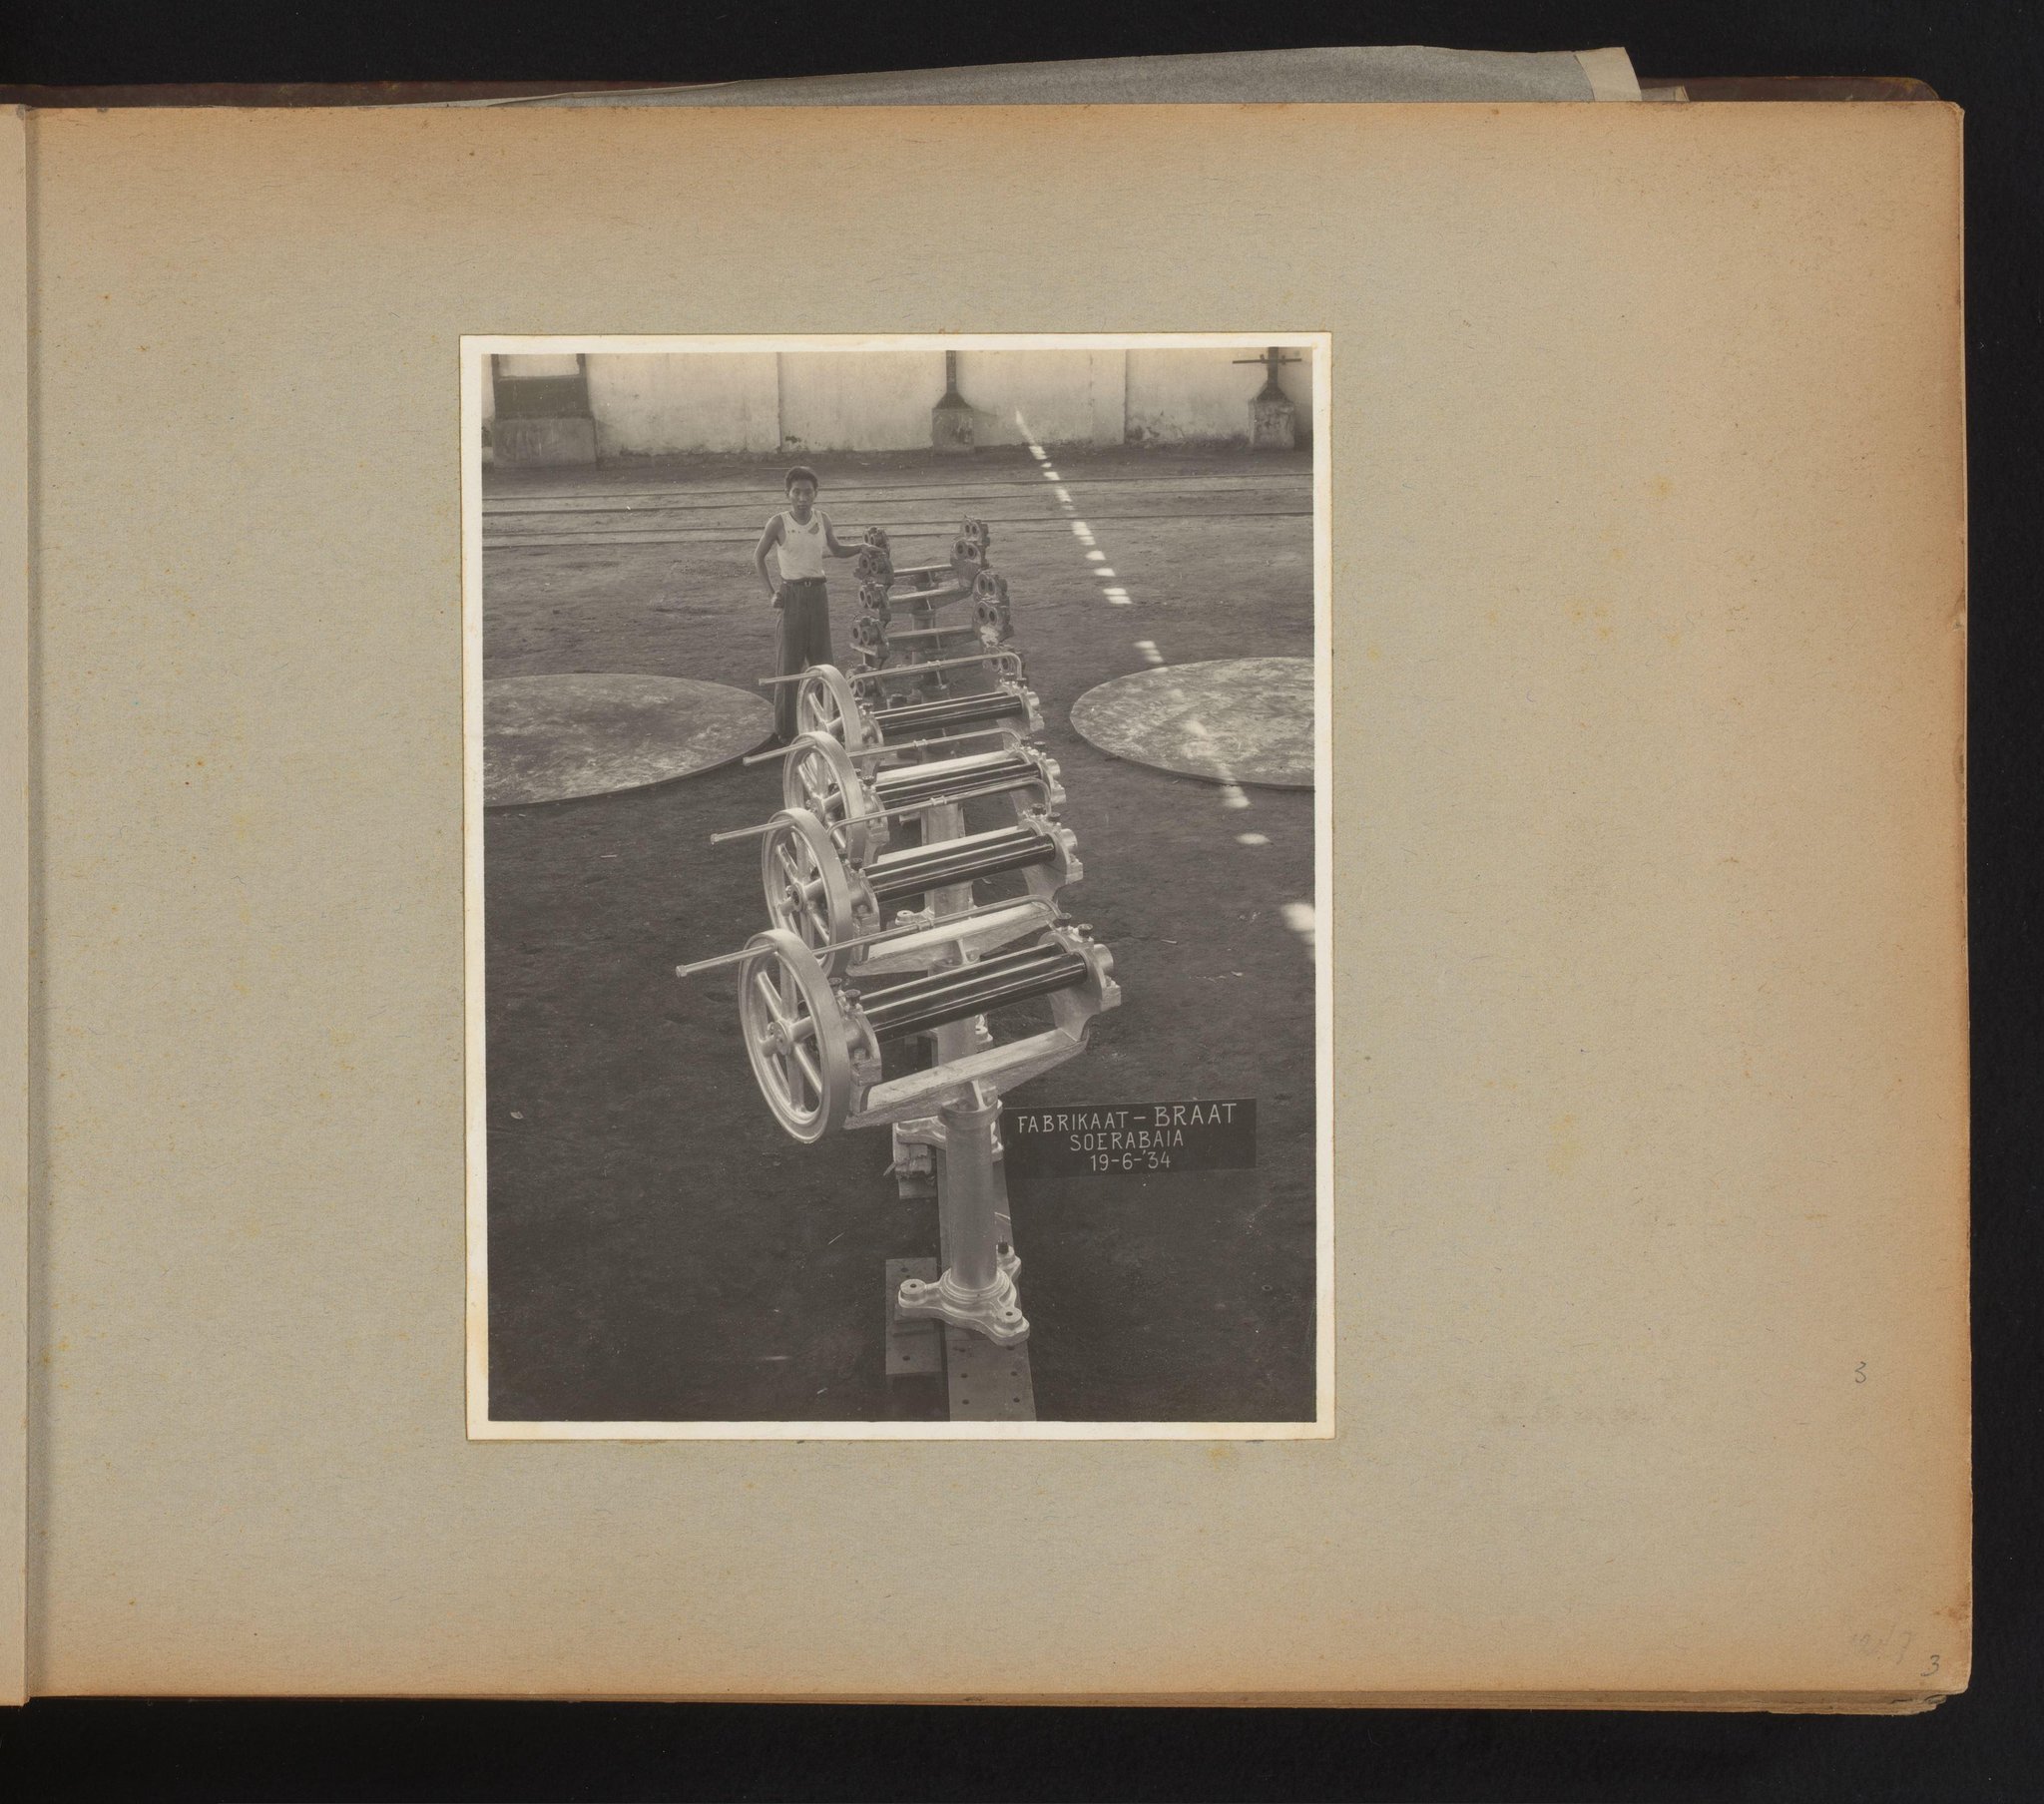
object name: photograph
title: Rollenpers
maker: Anonymous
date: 1934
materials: cardboard, photographic support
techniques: gelatin silver print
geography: surabaya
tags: parts of machines, java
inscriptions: date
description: Albumblad met een foto van rollenpers in serieproductie, vervaardigd in 1934. Onderdeel van een fotoalbum met foto's van machines en constructies van de N.V. Machinefabriek Braat te Soerabaja, Soekaboemi en Tegal uit de periode 1931-1937.